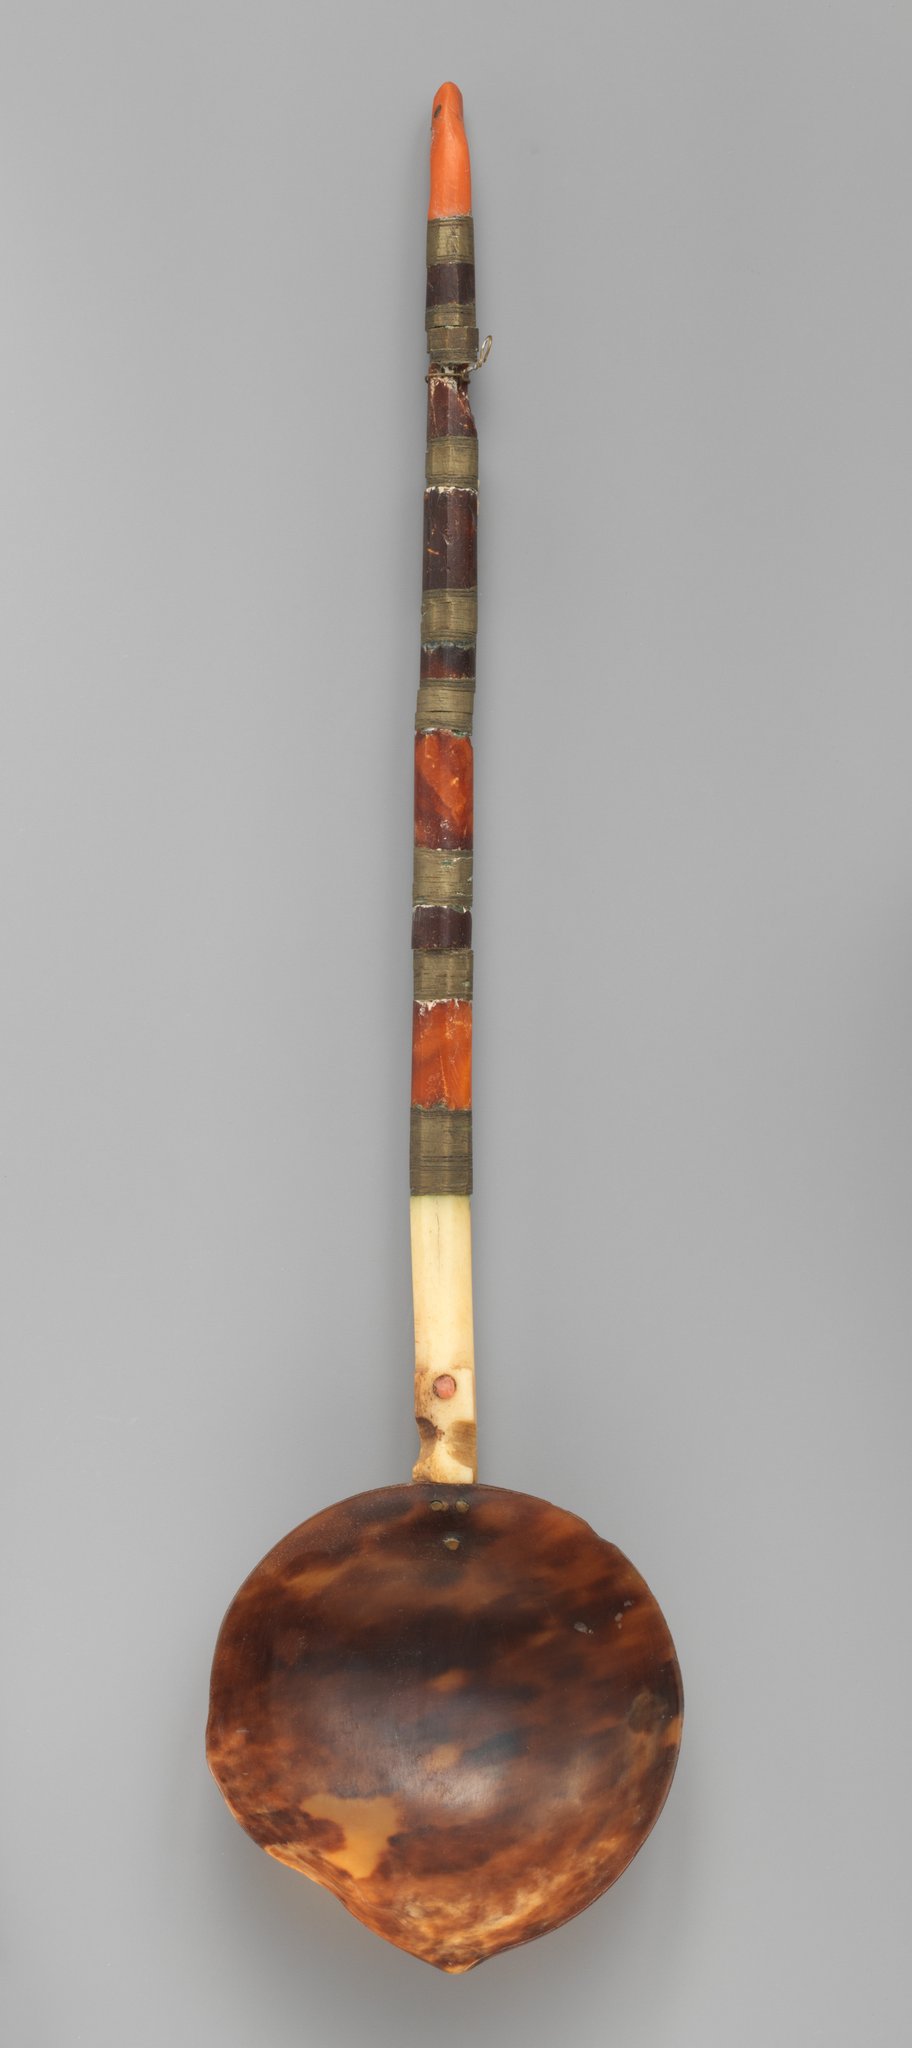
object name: spoon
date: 1701-1800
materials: amber, bone, brass, coral, shell